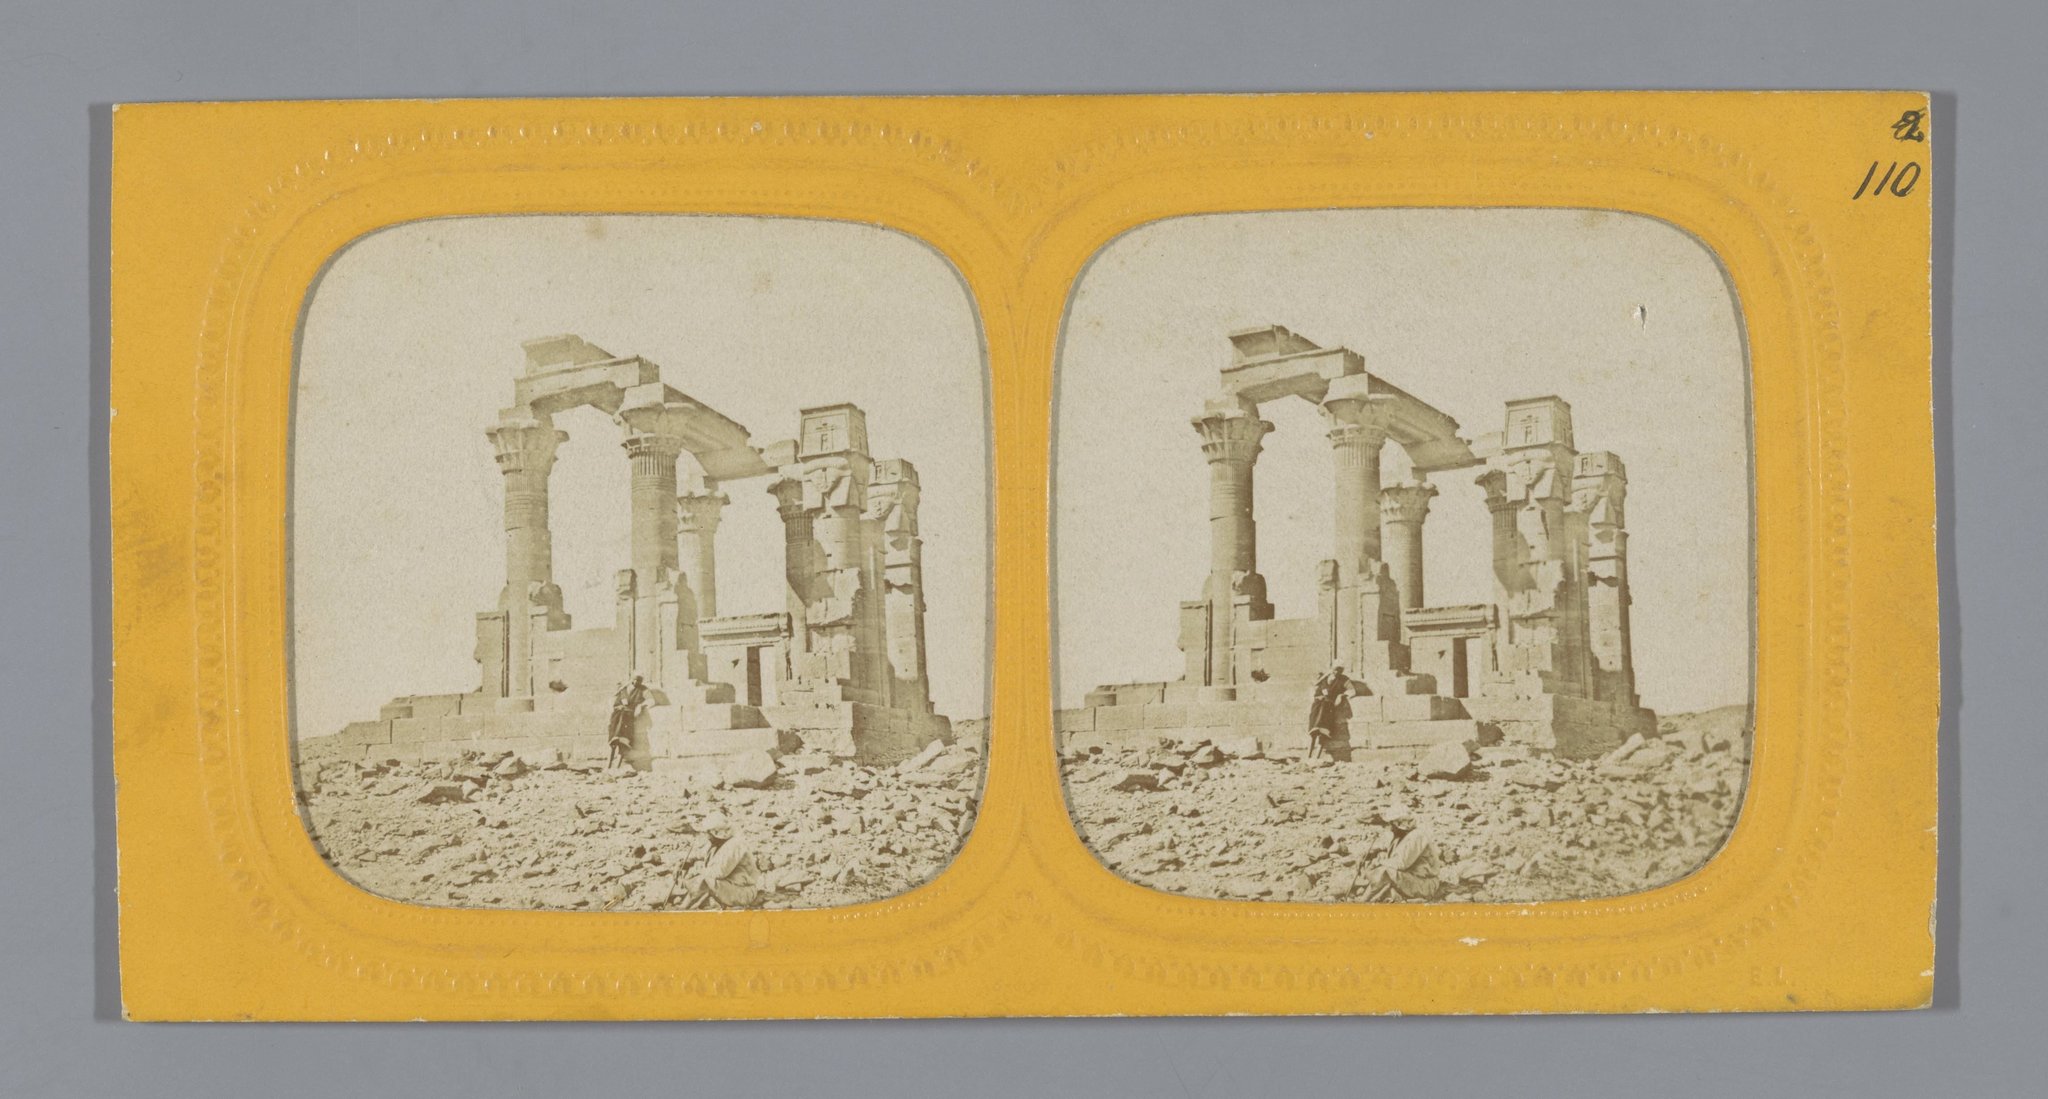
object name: tissue stereograph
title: Kalabsha tempelruïne in Nubië, Egypte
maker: Anonymous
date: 1858-1875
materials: cardboard, paper, photographic support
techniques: albumen print, hand coloring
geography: nubia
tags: temple, shrine ~ egyptian religion, ruin of a building ~ architecture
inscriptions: number: ‘110’, monogram: ‘E.L.’